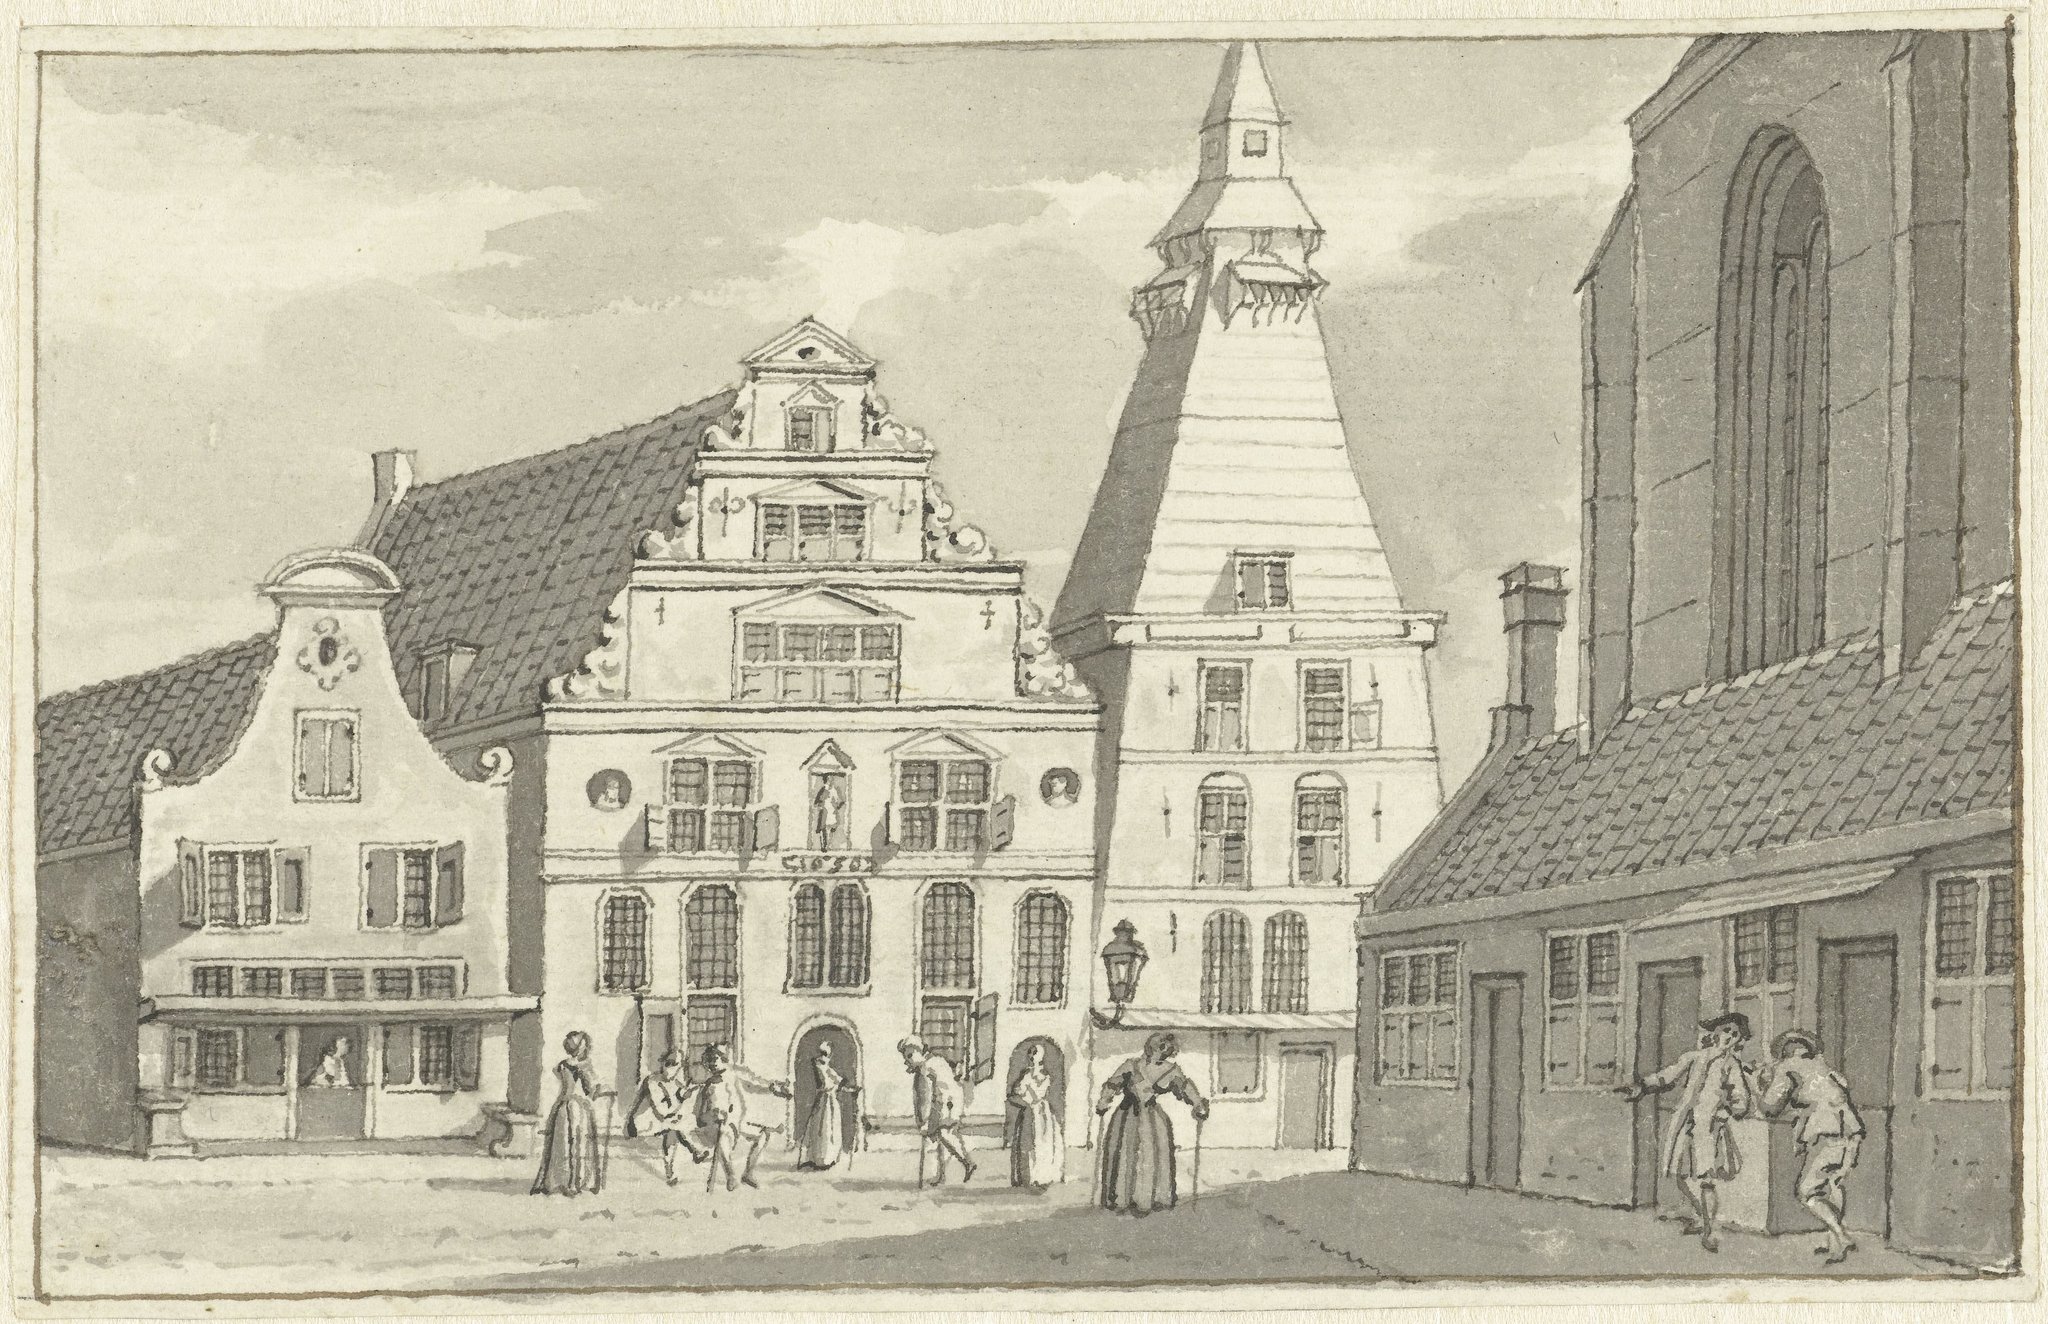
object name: drawing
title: Het Klokkehuis en Gasthuis te Hoorn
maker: Anonymous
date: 1701-1809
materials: ink, paper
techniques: brush, pen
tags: hospital, hoorn (north holland)